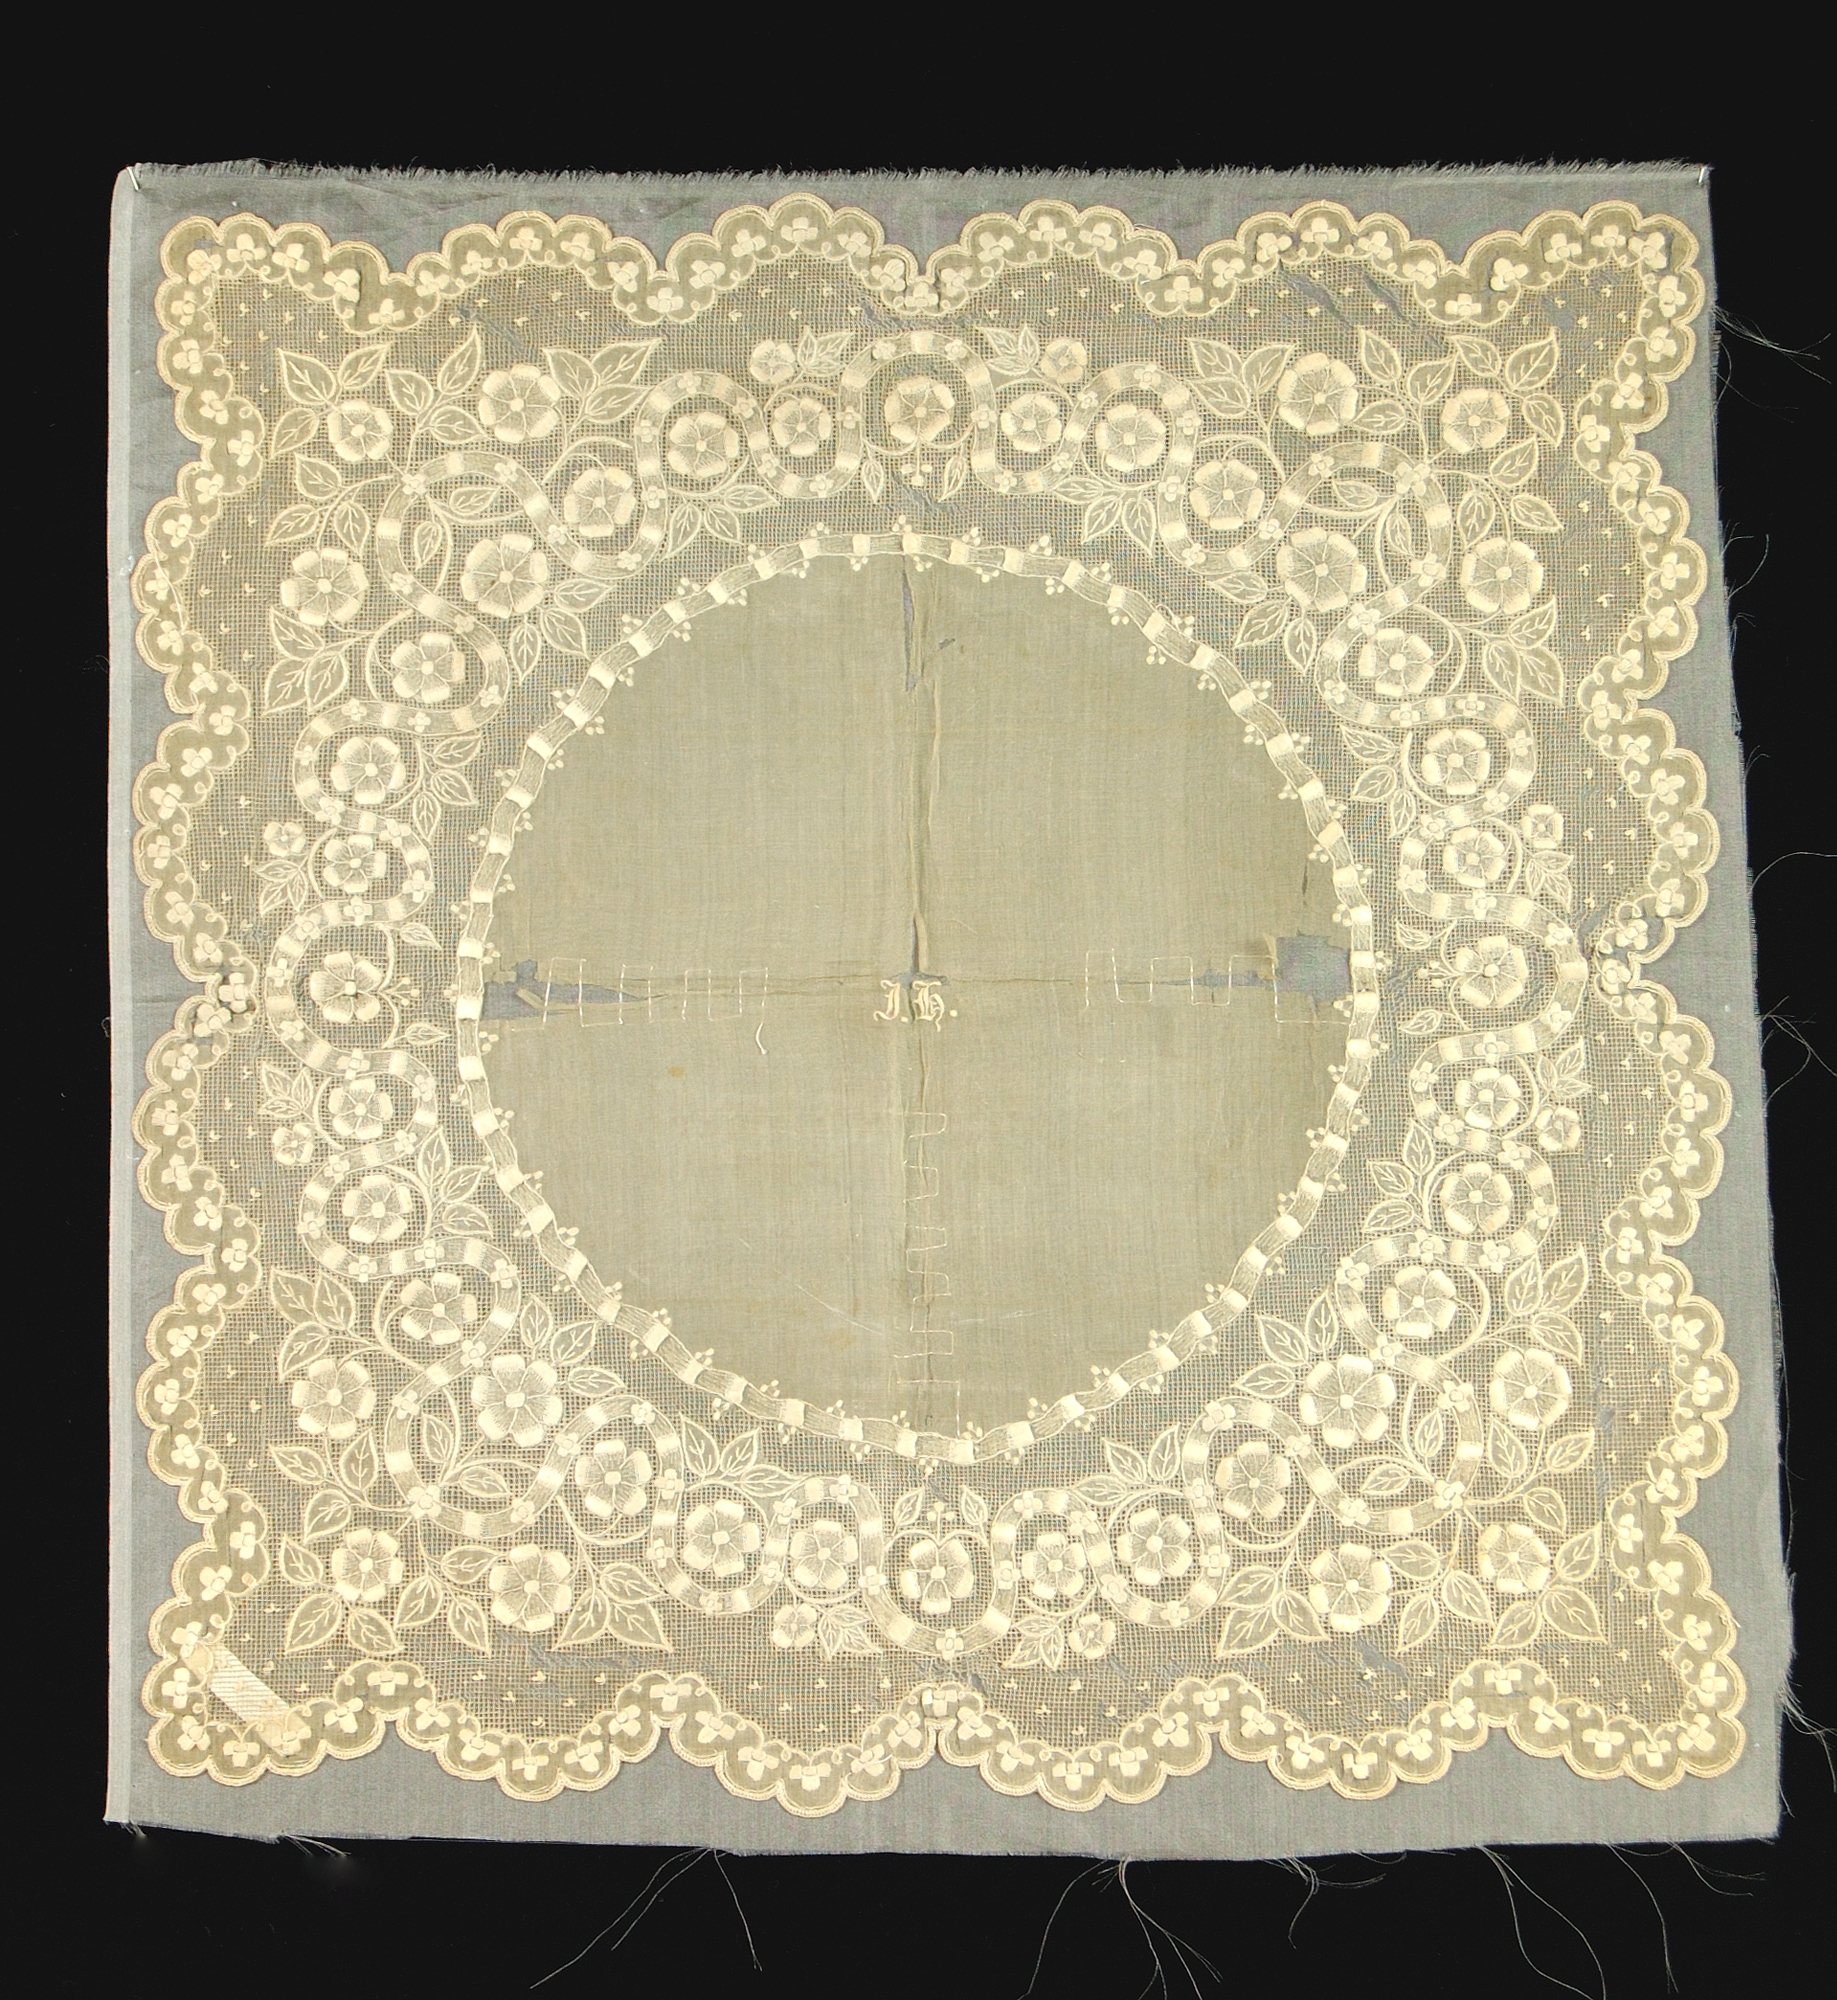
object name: handkerchief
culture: philippine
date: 1851-1875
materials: fiber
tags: flowers